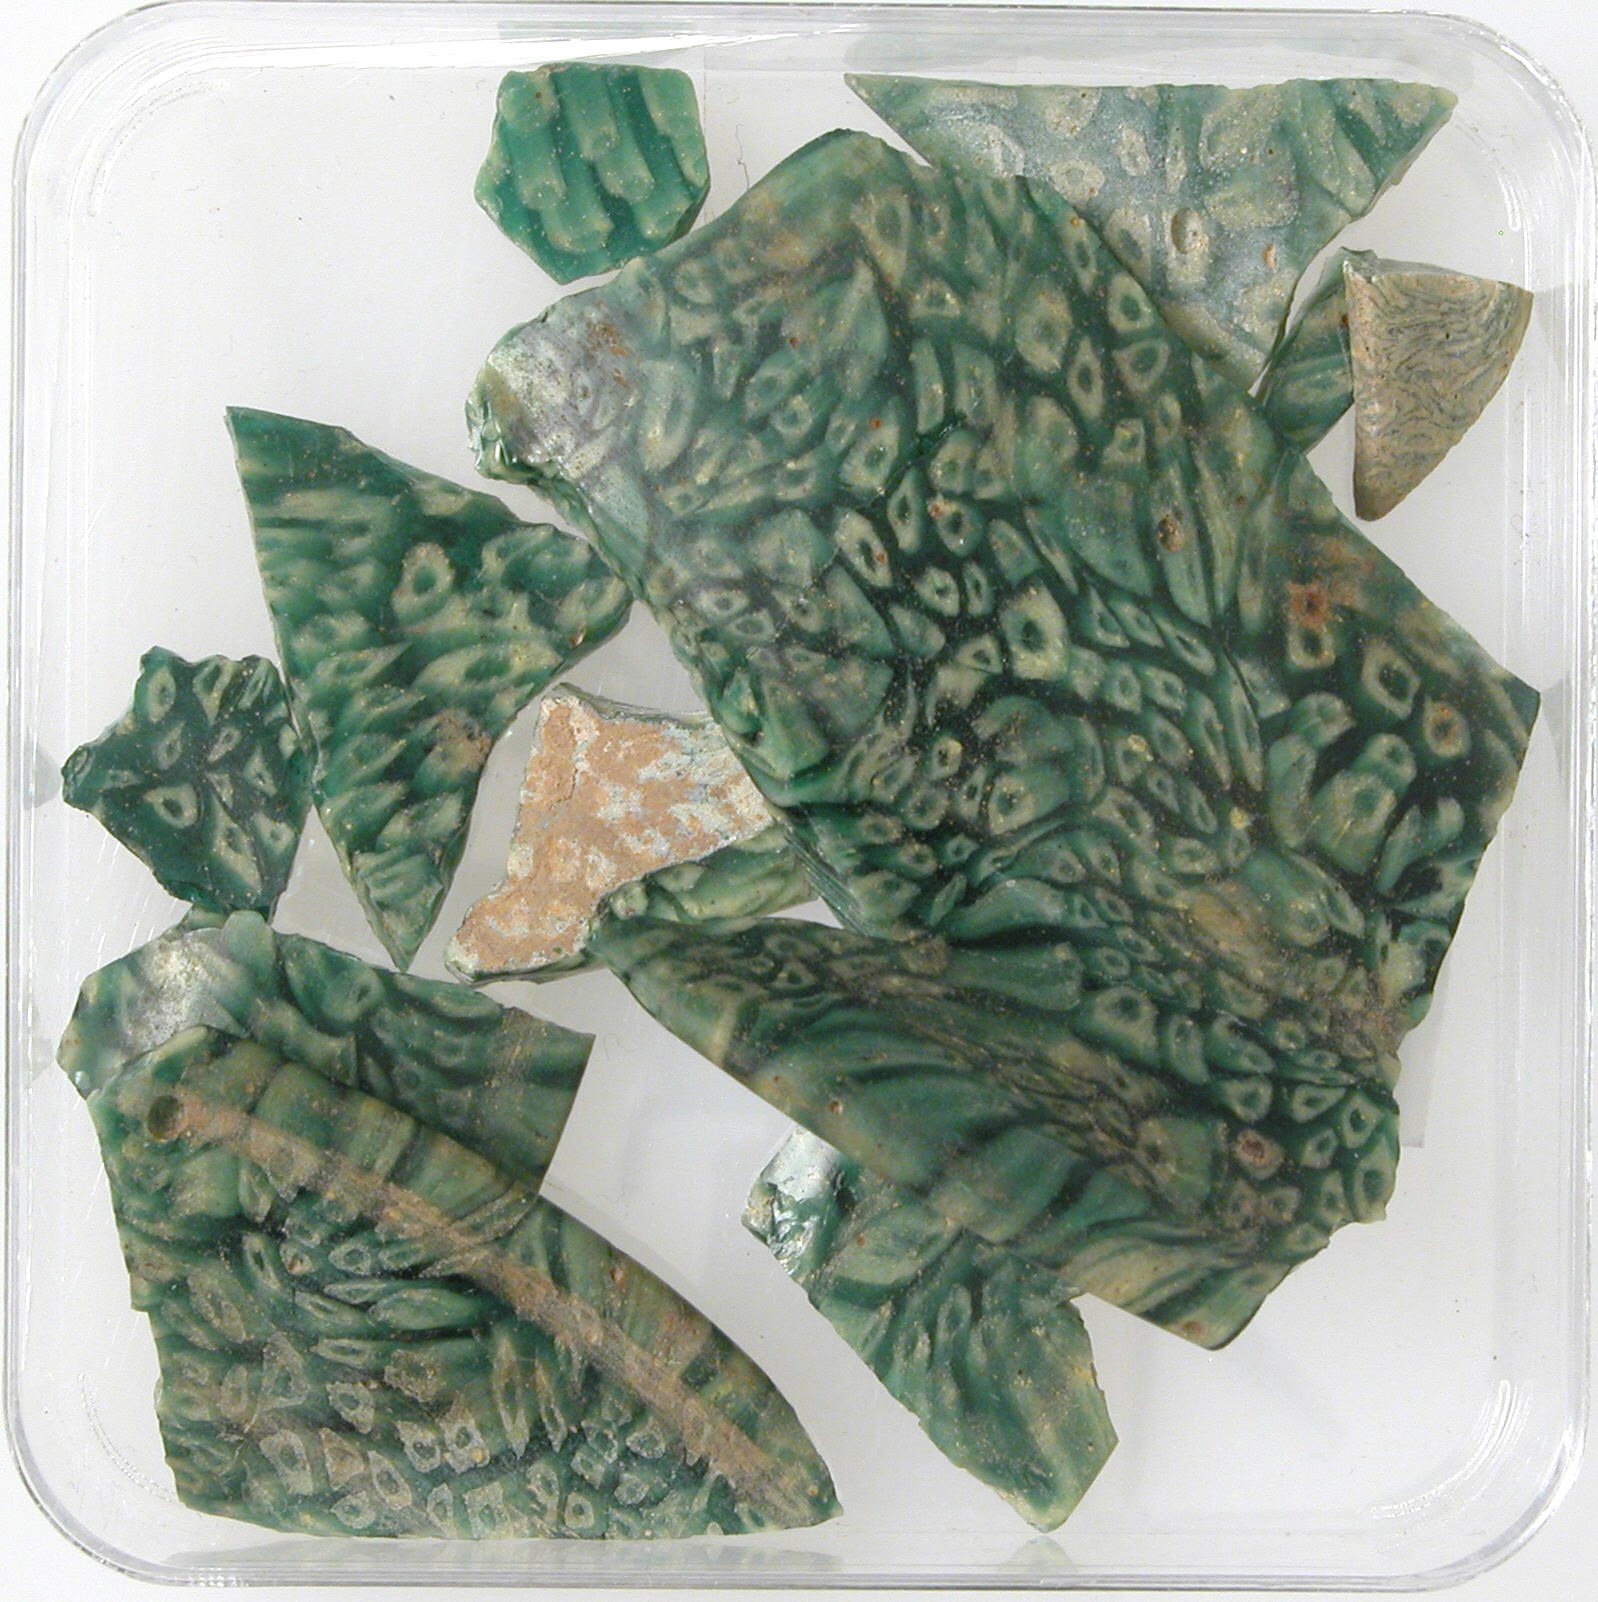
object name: fragment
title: Glass Fragments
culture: coptic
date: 301-433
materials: glass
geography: egypt